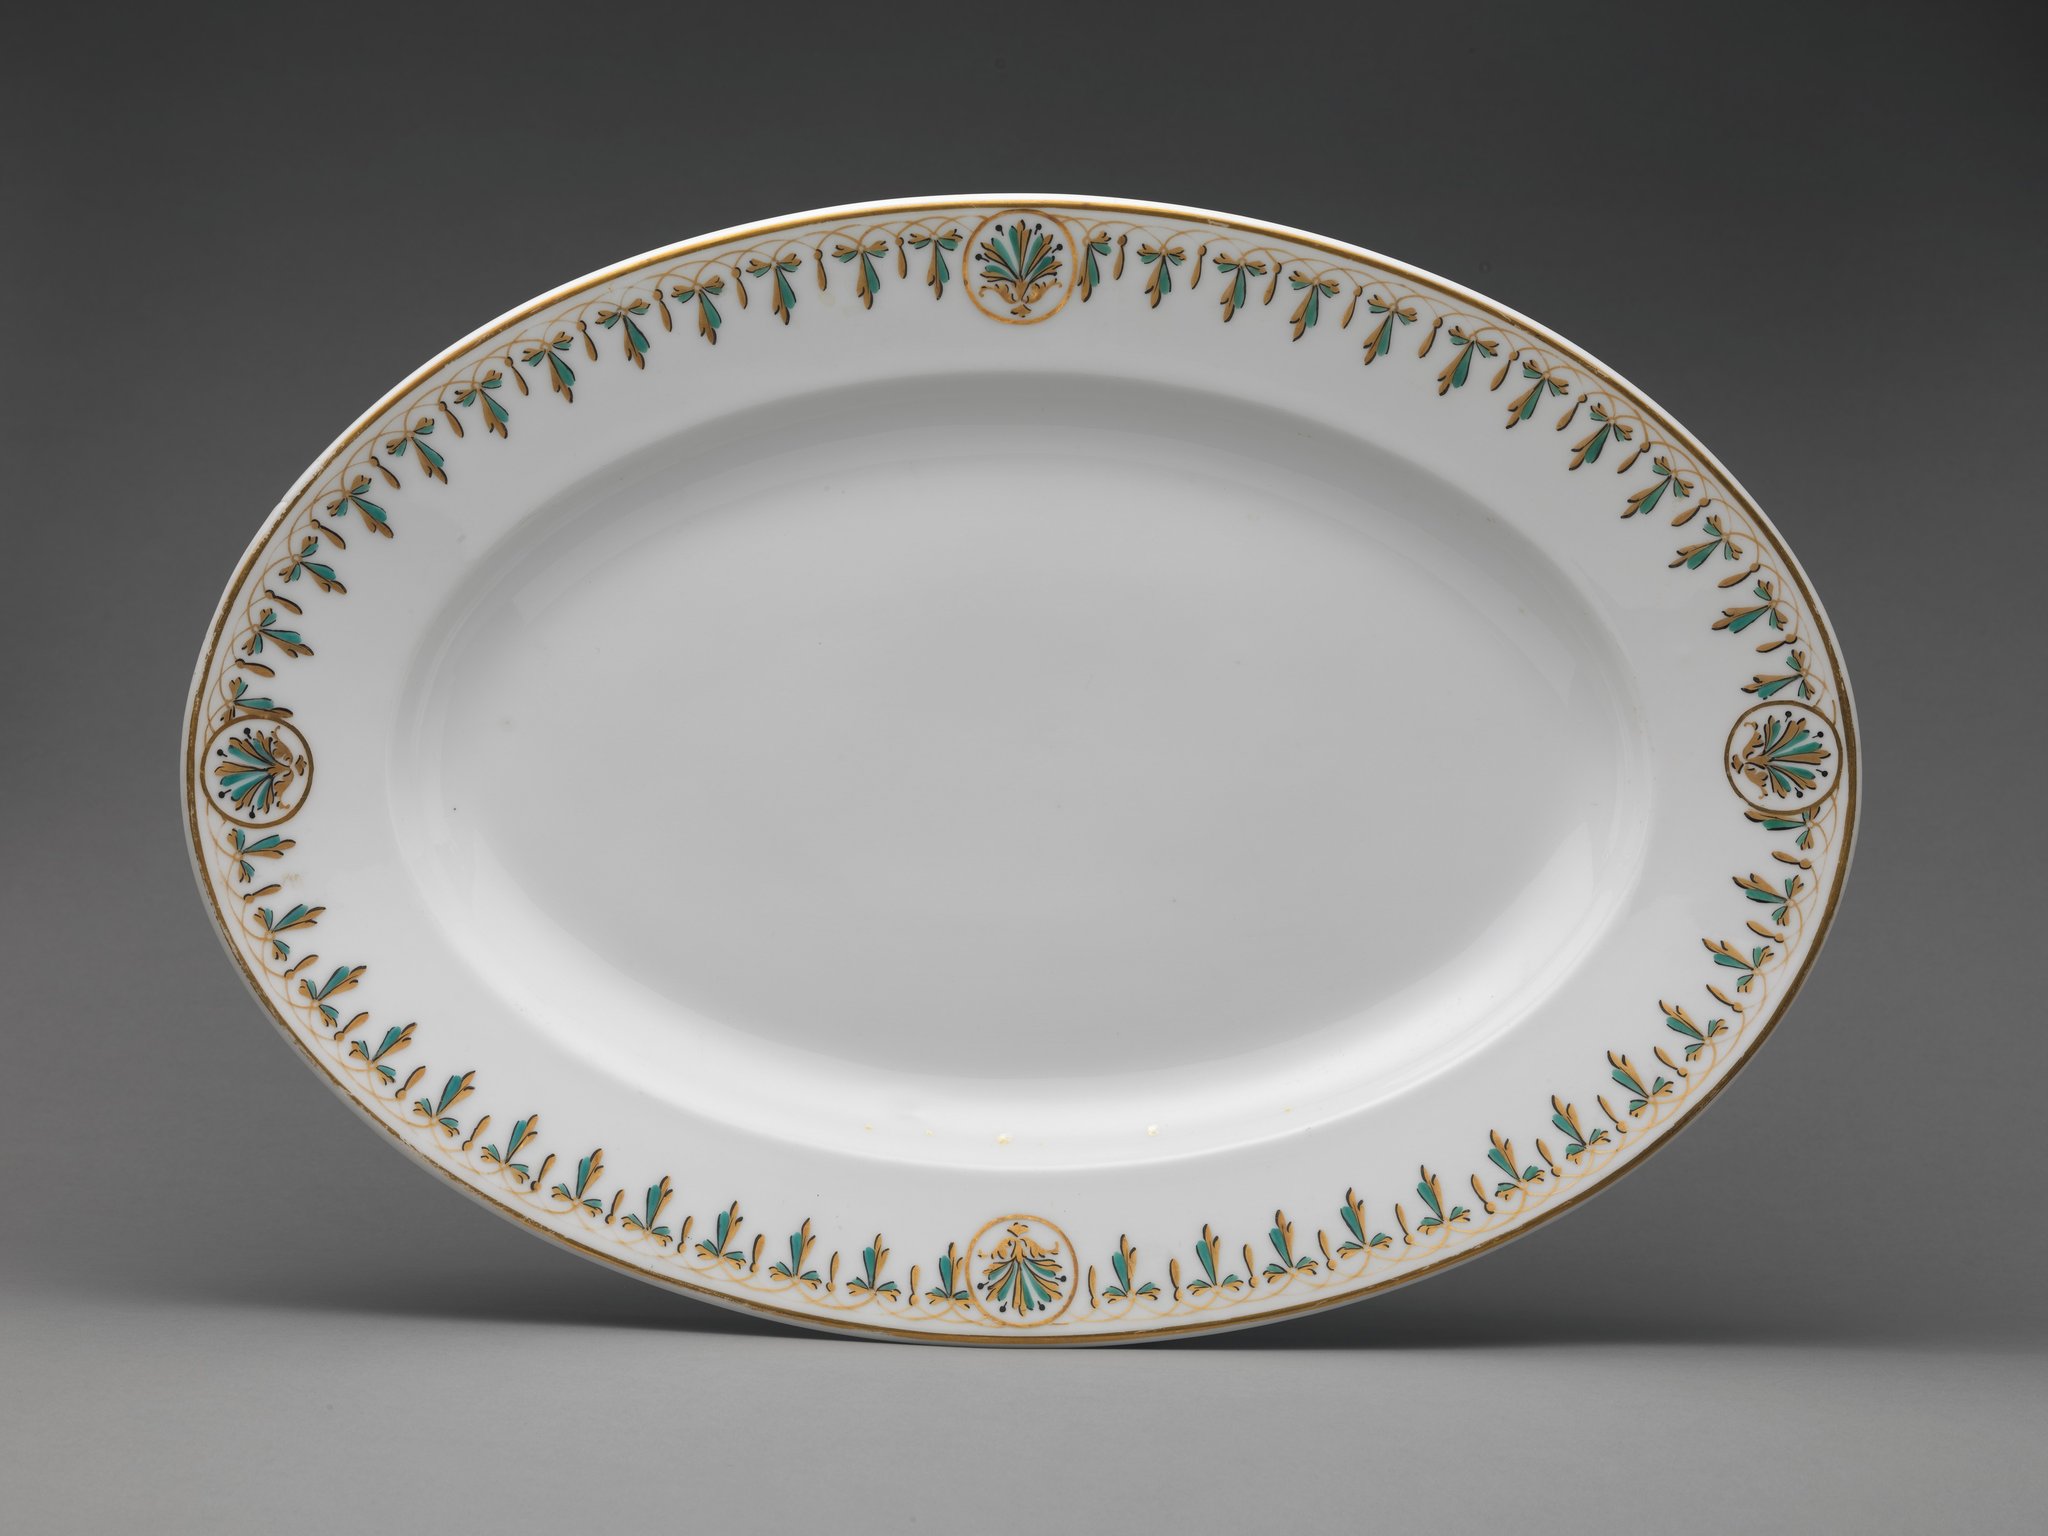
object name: platter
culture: american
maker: union porcelain works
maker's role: maker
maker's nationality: american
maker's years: 1863-1922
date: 1885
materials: porcelain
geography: united states